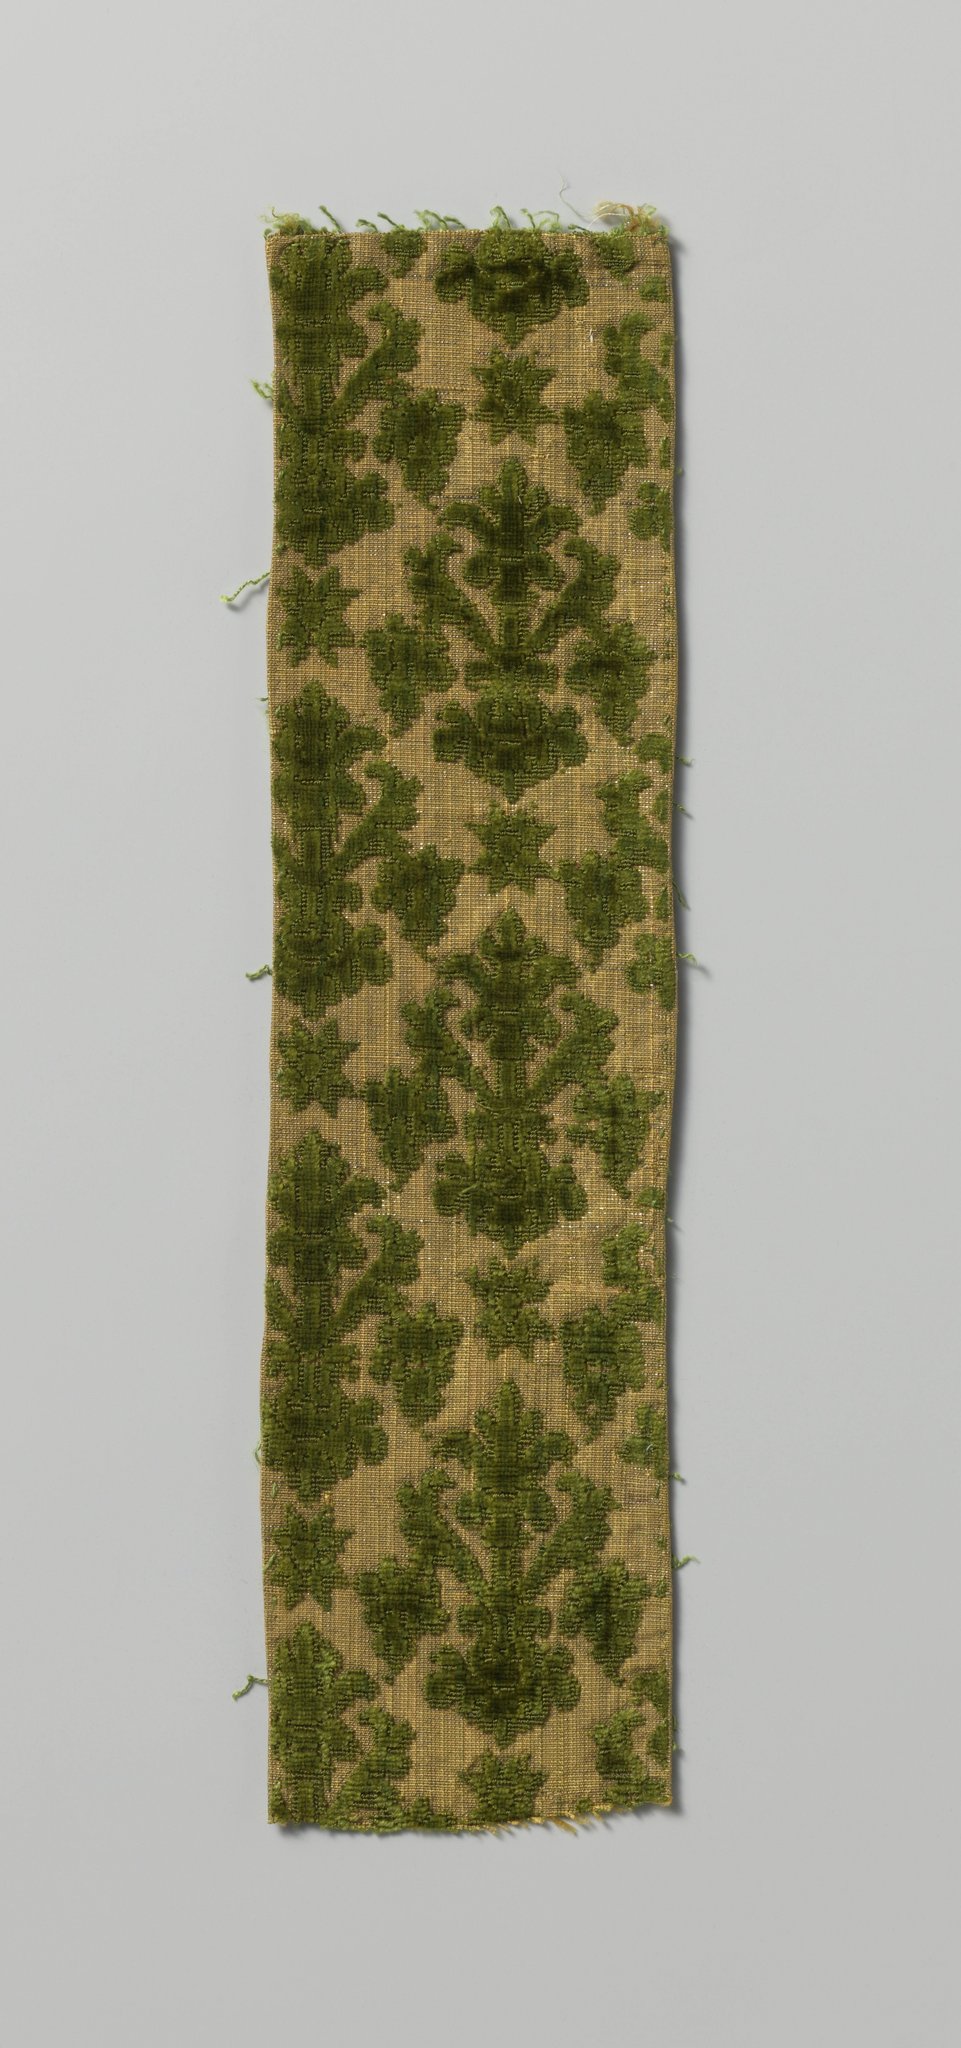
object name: zijdefluweel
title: Fragment zijdefluweel met op goudgele grond verspringende rijen palmetbloemen en stervormen in groen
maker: Anonymous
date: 1500-1599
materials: silk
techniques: velvet, weave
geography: italy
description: Fragment zijdefluweel met op goudgele grond verspringende rijen palmetbloemen en stervormen in groen. Italië, 16de eeuw.